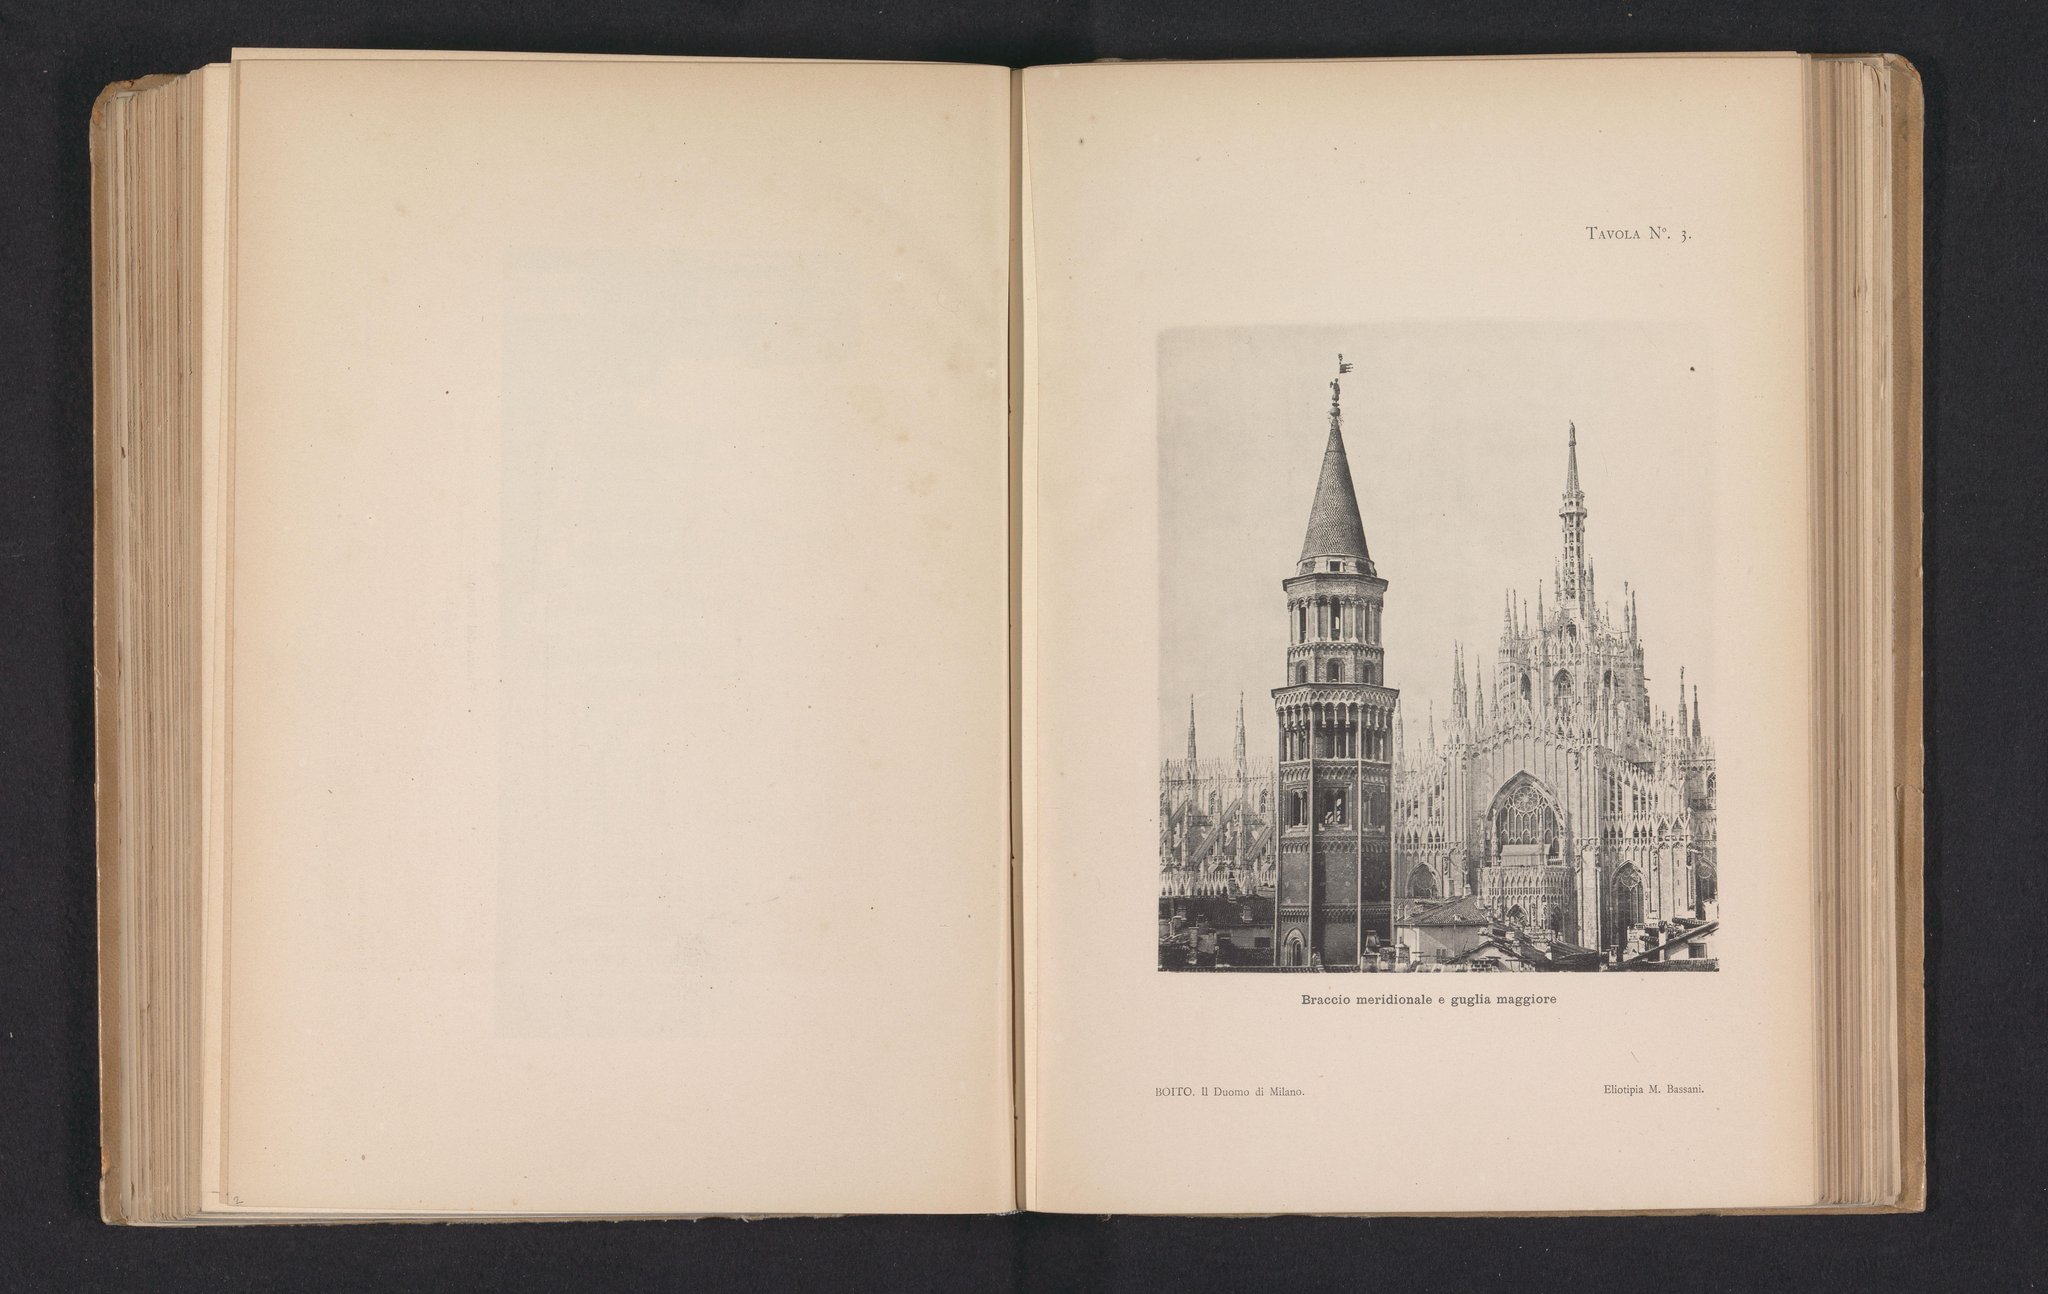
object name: page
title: Braccio meridionale e guglia maggiore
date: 1879-1889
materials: paper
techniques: photograph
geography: milan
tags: church (exterior), parts of church exterior and annexes: spire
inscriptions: number: ‘Tavola No. 3.’